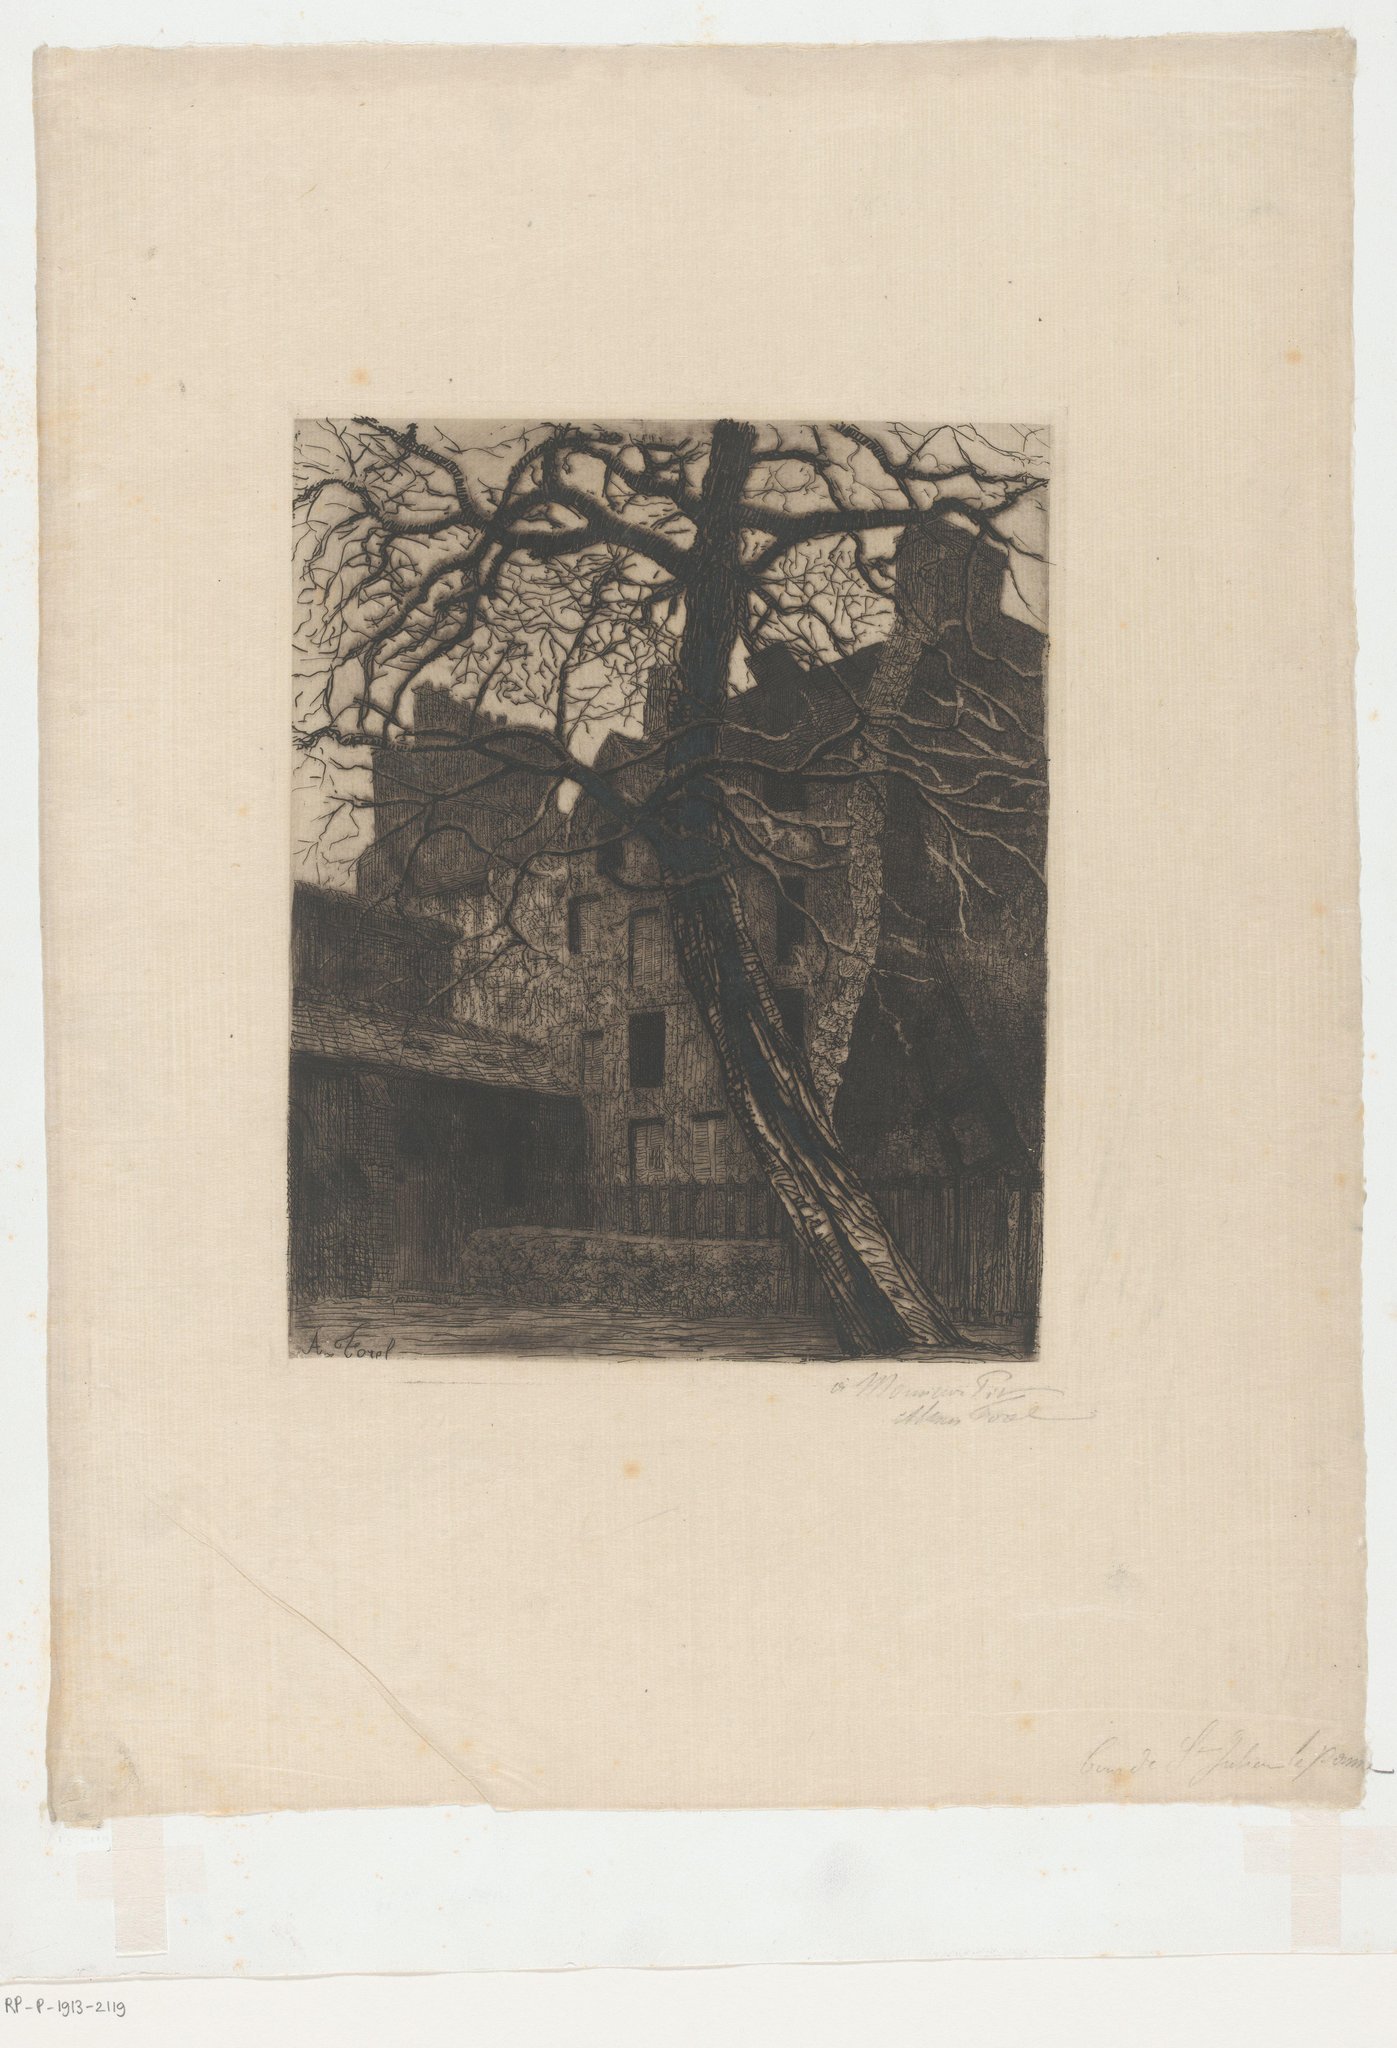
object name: print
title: Binnenplaats van de Église Saint-Julien-le-Pauvre te Parijs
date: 1862-1913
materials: paper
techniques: etching, intaglio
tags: courtyard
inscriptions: collector's mark: Lugt 2228